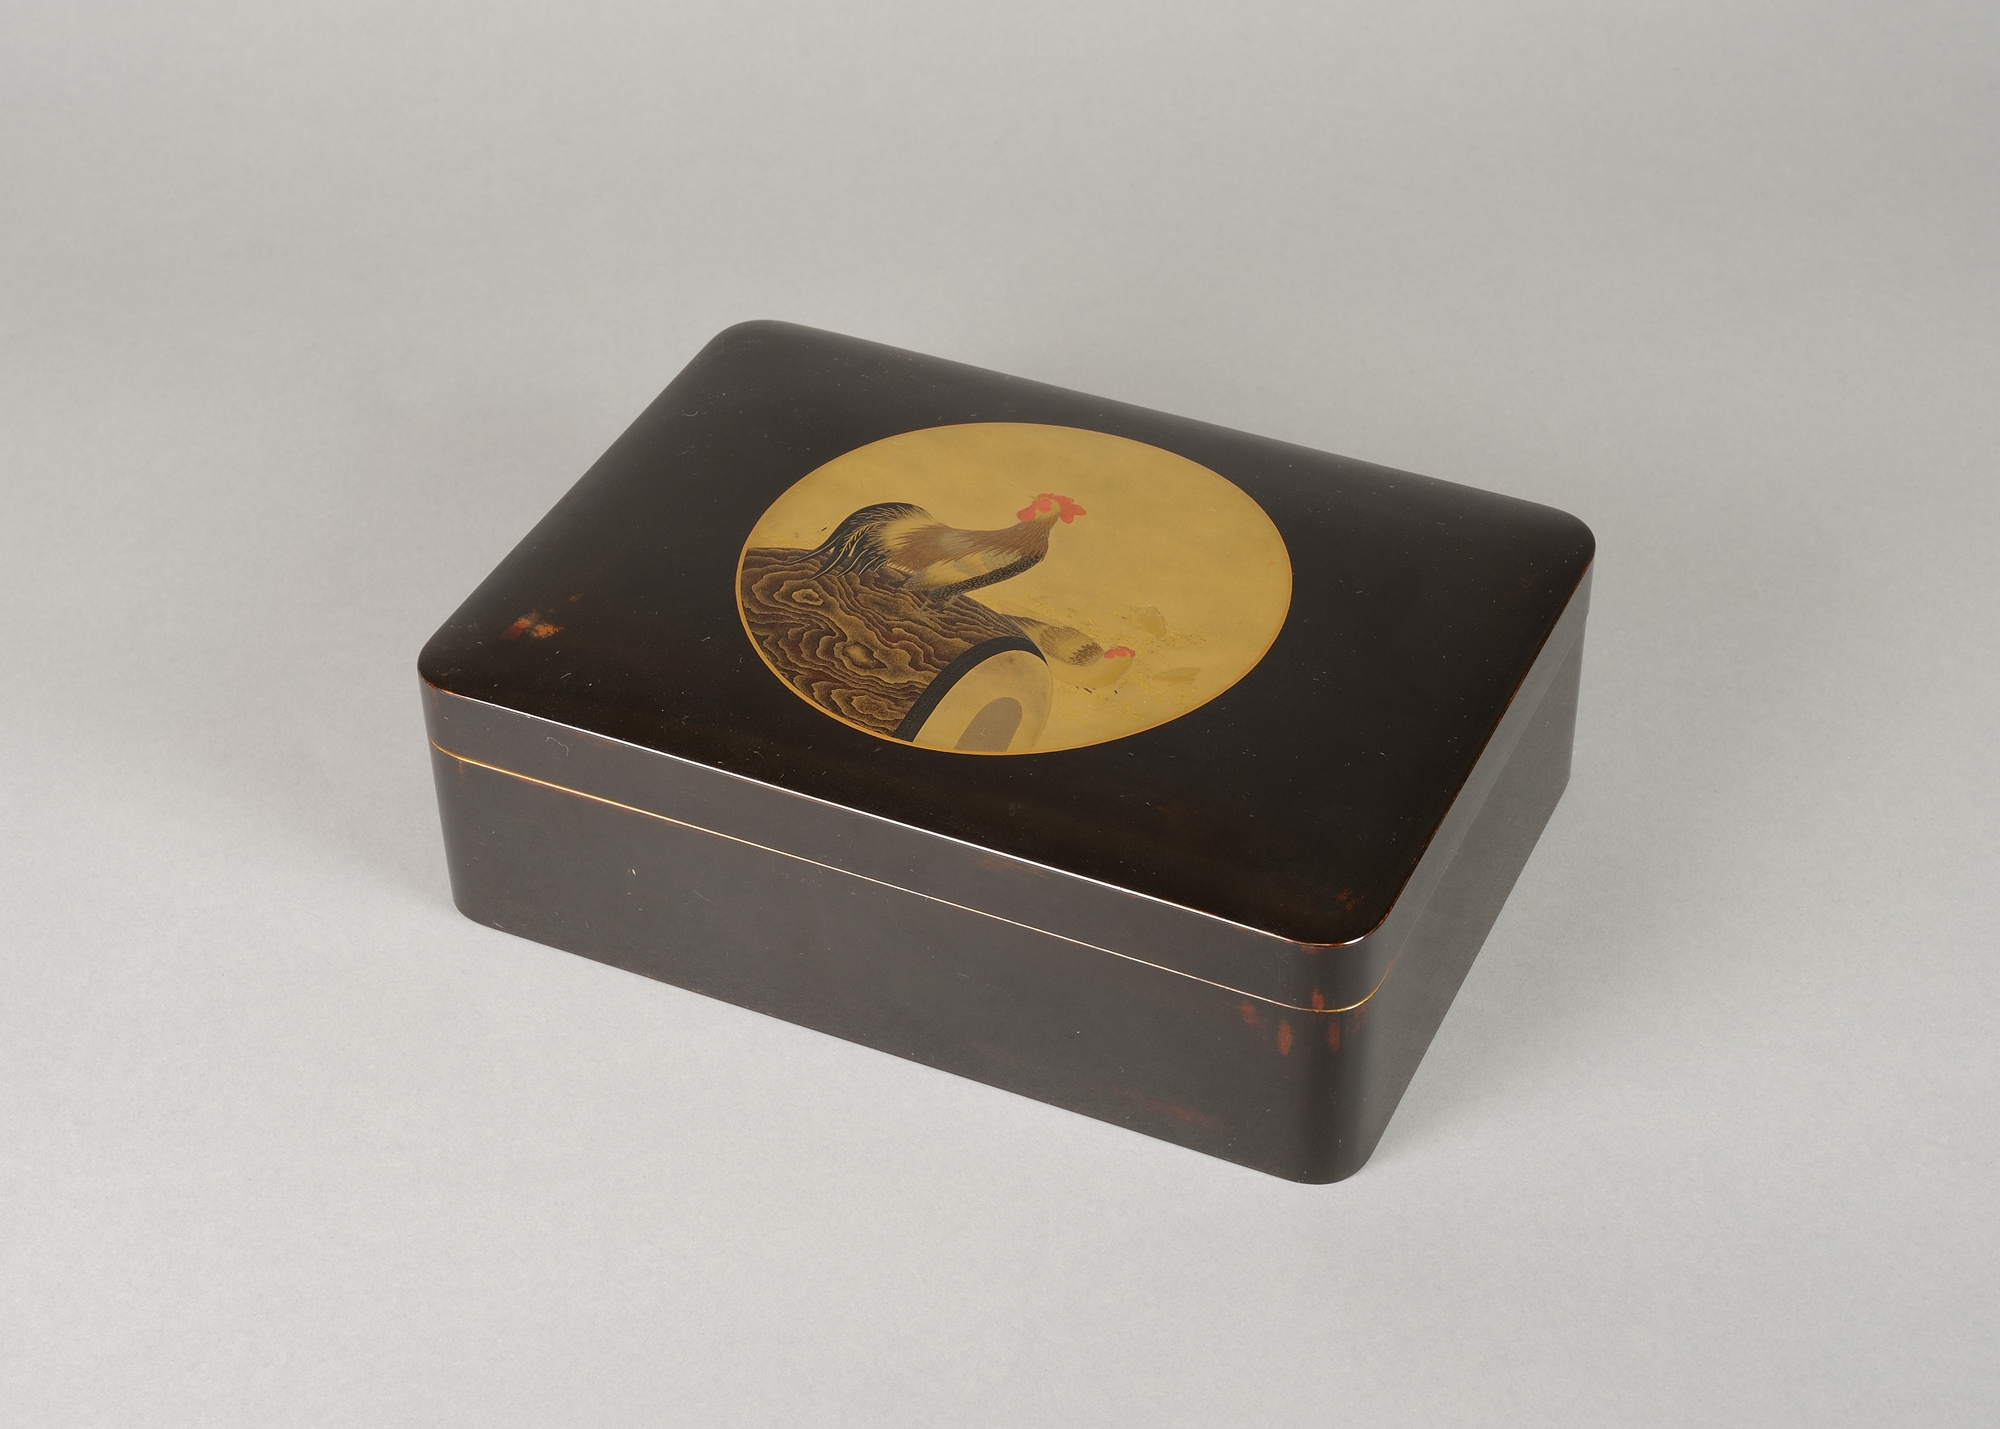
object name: box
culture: japanese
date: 1801-1900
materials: lacquer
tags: roosters